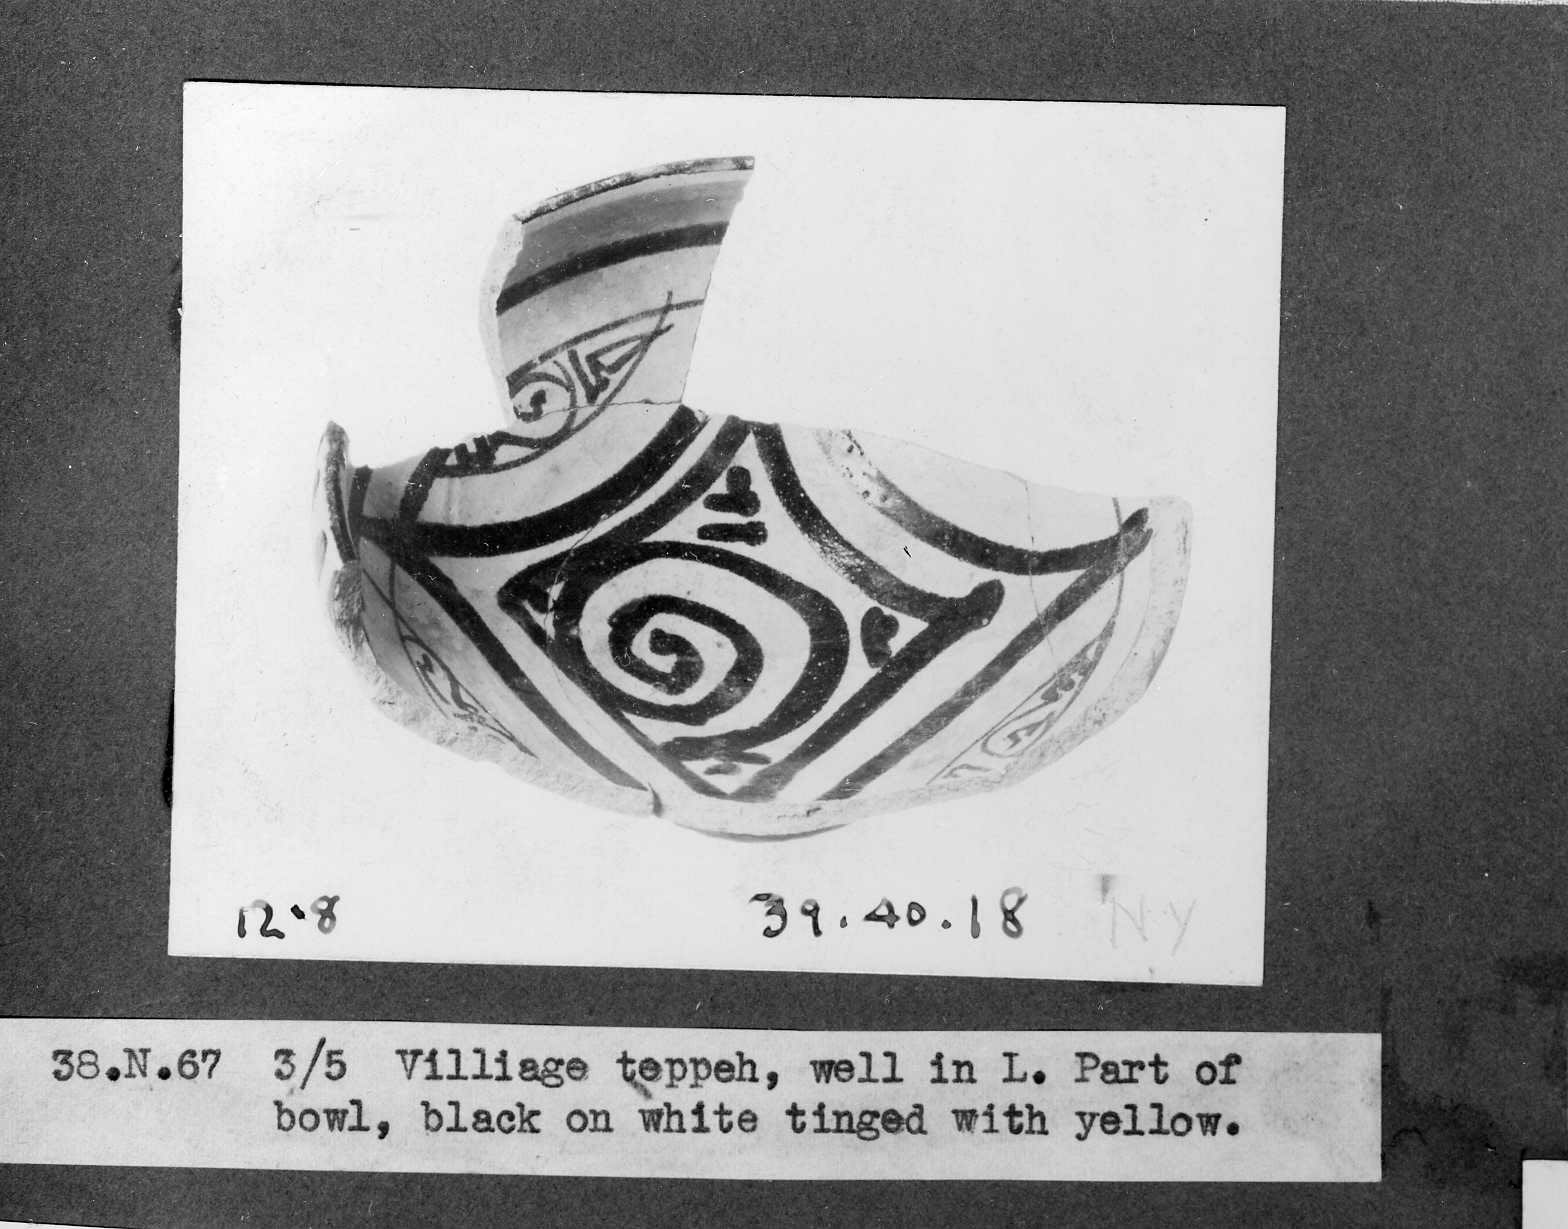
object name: bowl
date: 801-1000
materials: earthenware, glaze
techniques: polychrome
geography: iran